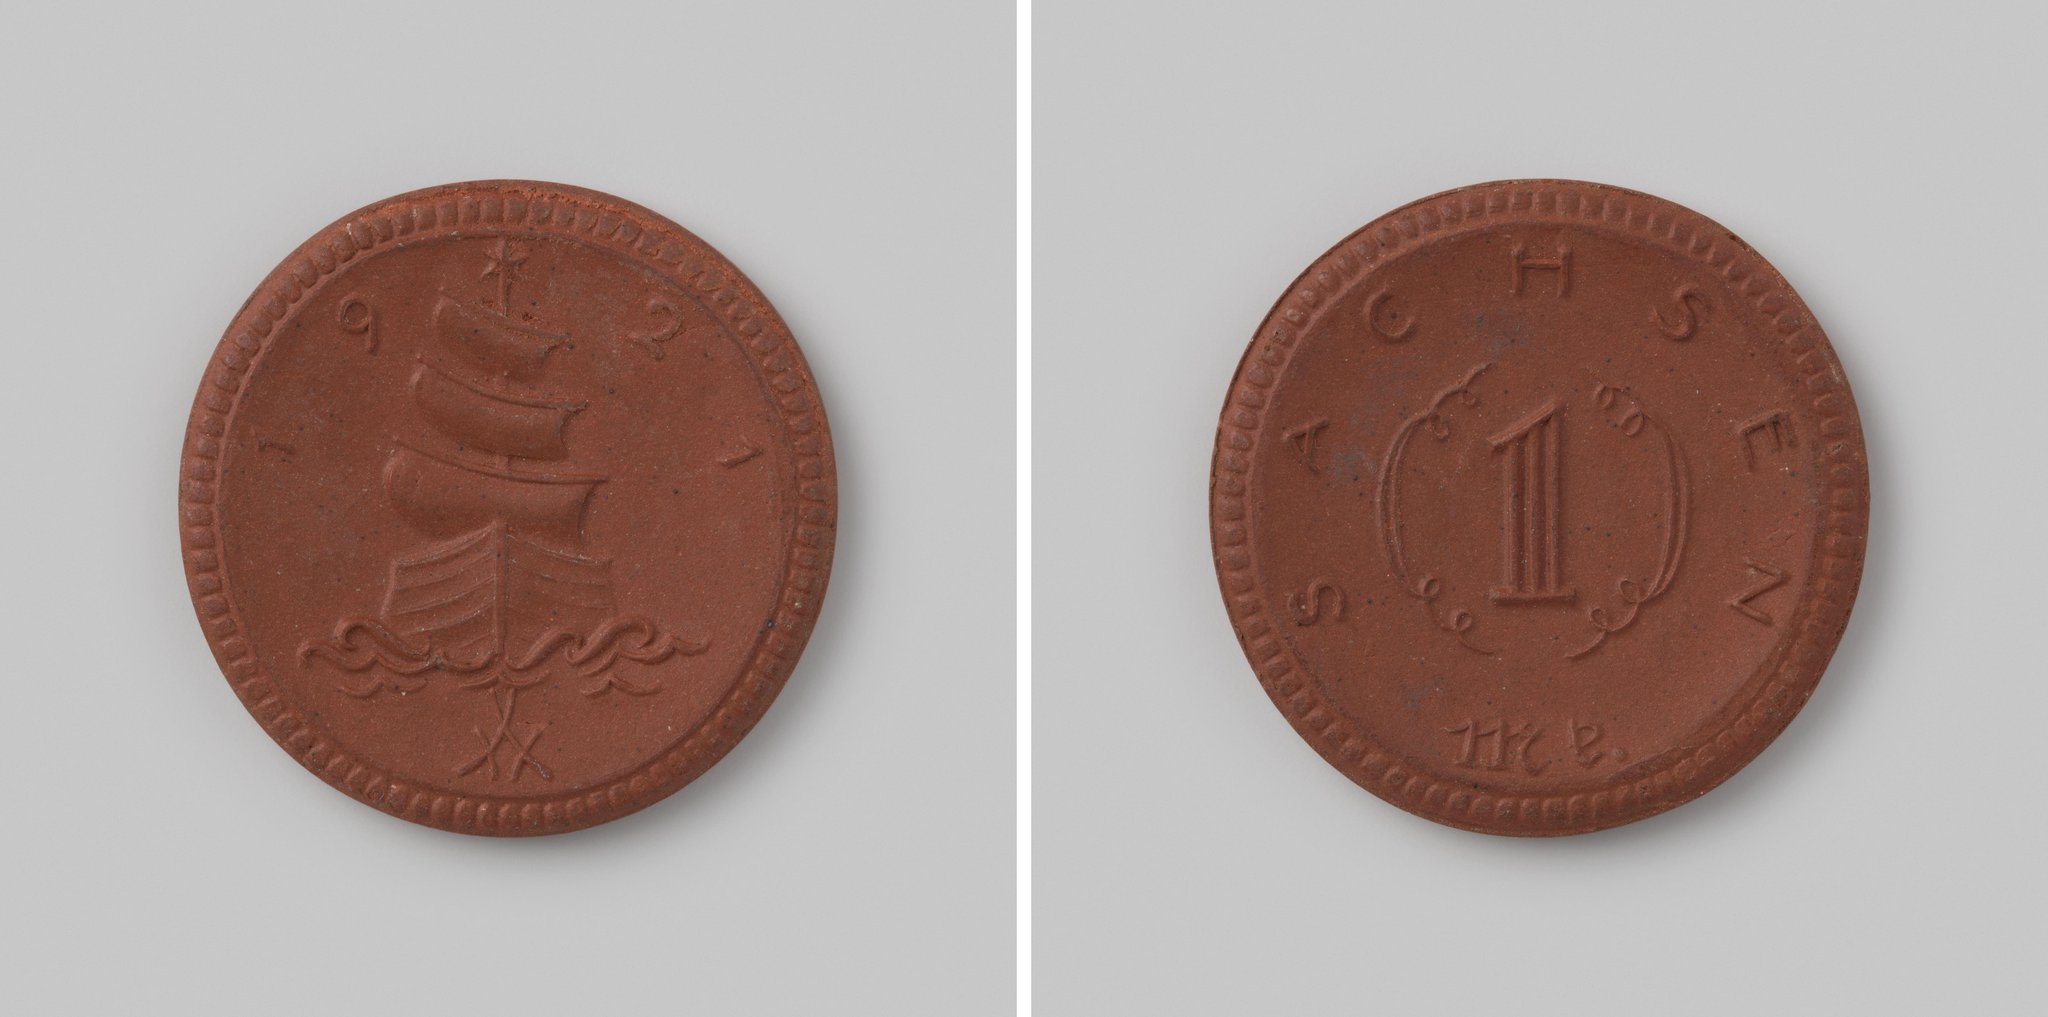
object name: coin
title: Mark uit Duitsland, Saksen, 1921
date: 1921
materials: porcelain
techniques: casting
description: Porseleinen pseudomunt. Voorzijde: schip met volle zeilen op zee, waarboven jaartal. Keerzijde: binnen versiering waarde-aanduiding in twee regels. Daaromheen land-aanduiding. Gladde rand.